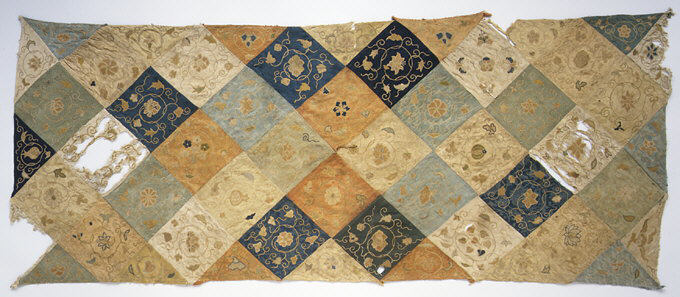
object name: patchwork panel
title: Embroidered Patchwork Panel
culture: chinese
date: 1301-1400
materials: textile, gilt, paper, silk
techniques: damask, embroidery, weave